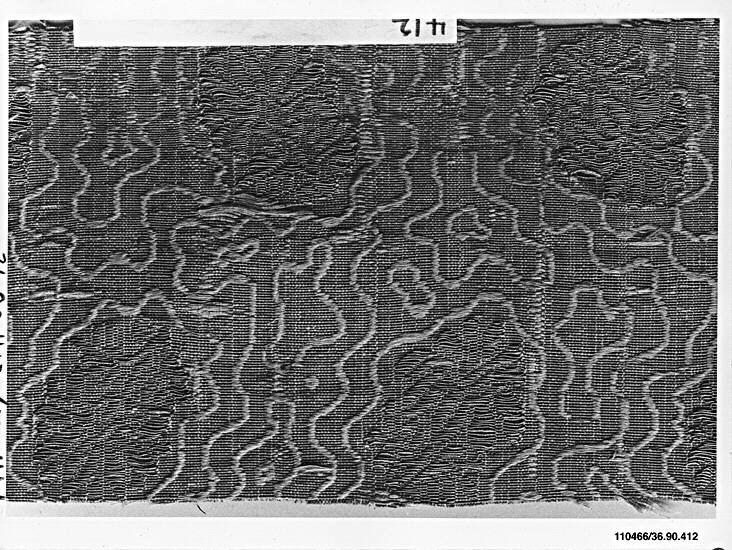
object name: piece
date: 1501-1700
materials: metal thread, silk